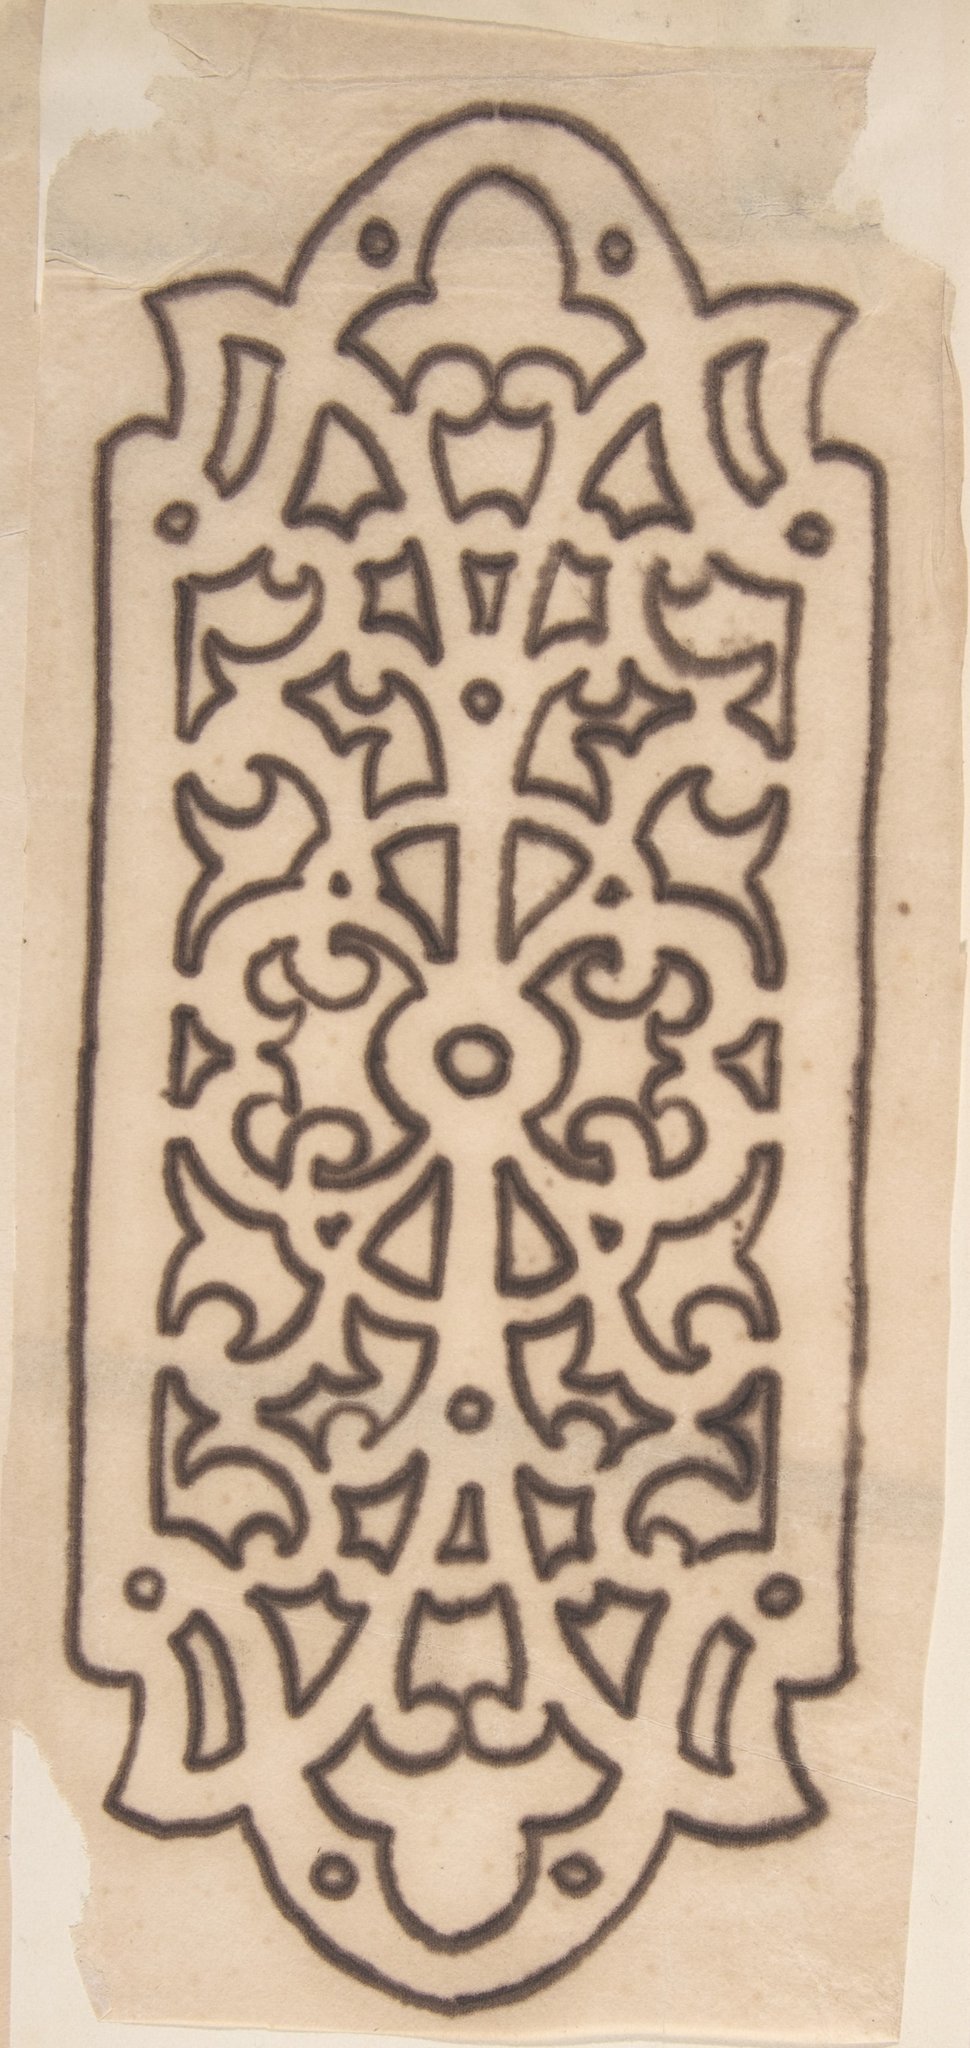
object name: drawing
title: Ornamented Metal Doorplate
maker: anonymous, british, 19th century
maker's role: artist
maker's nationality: british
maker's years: 1800-1900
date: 1851-1900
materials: ink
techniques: pen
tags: ornament